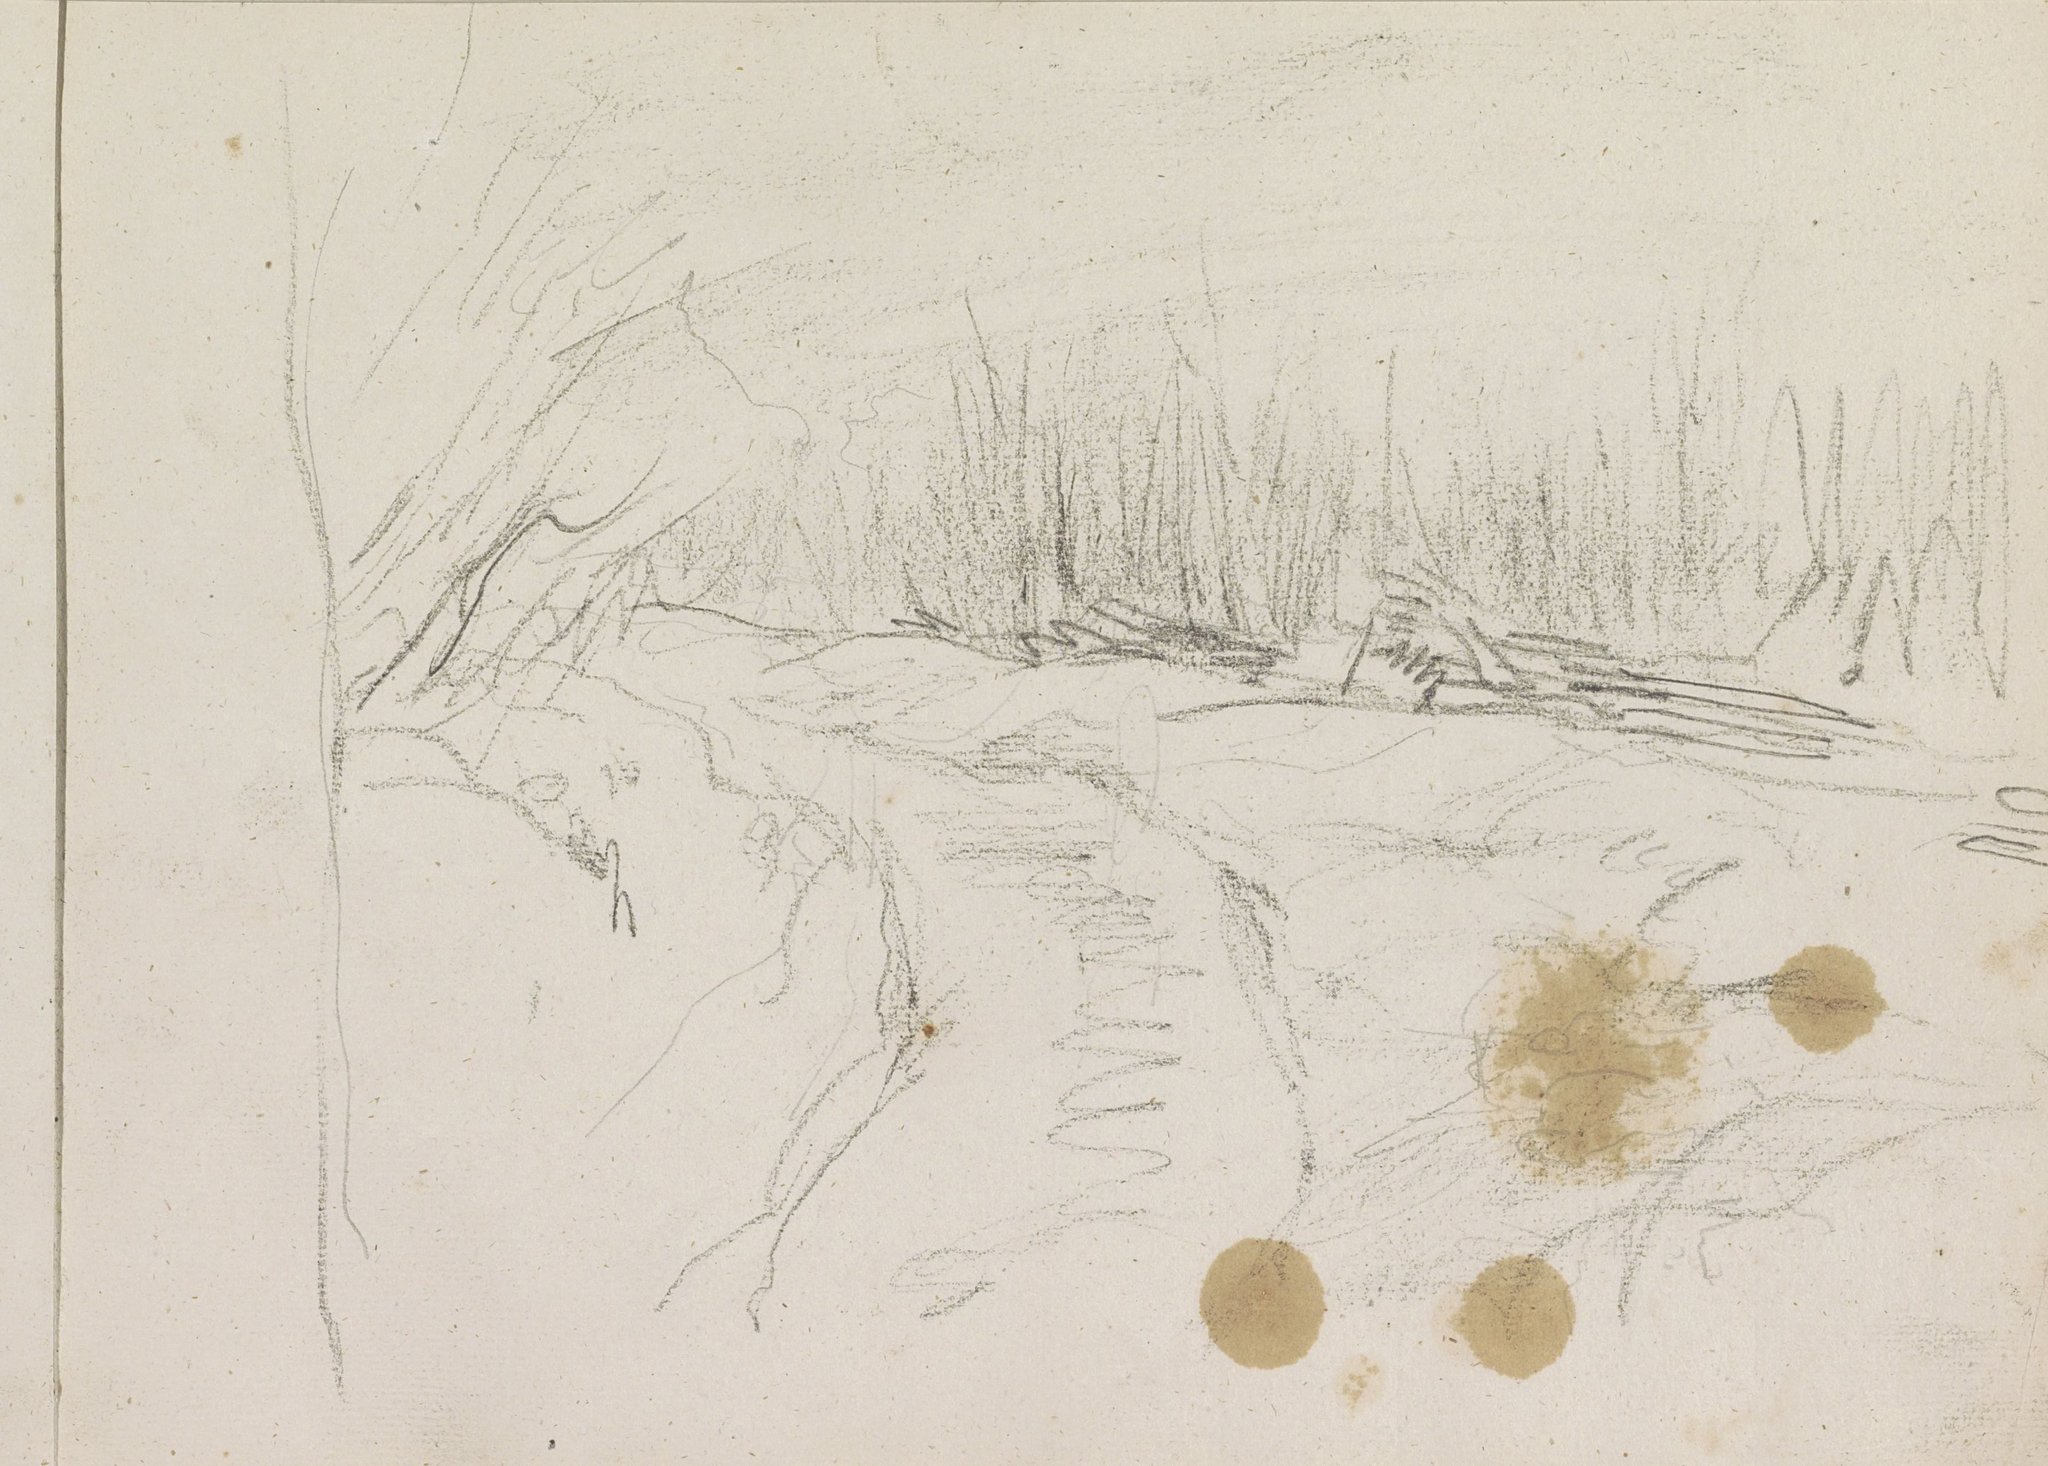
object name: sketchbook leaf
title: Landschap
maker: anton mauve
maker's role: draughtsman, painter, print maker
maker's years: 1838-1888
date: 1848-1888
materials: chalk, paper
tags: landscapes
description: Blad 13 recto uit een schetsboek met 34 bladen.